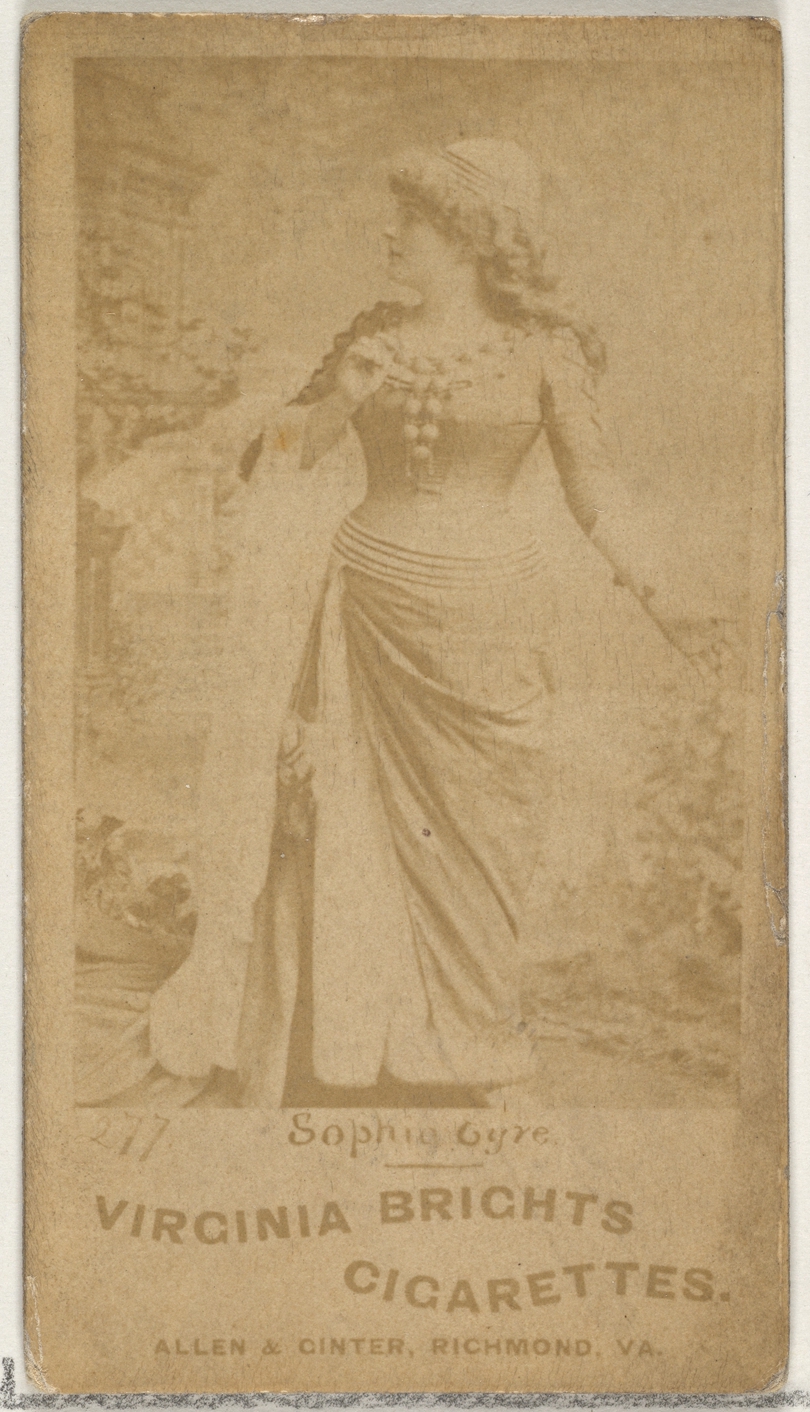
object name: photograph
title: Card 277, Sophie Gyre, from the Actors and Actresses series (N45, Type 1) for Virginia Brights Cigarettes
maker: allen & ginter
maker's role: publisher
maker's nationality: american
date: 1888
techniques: albumen silver print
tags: portraits,profiles,women,actresses